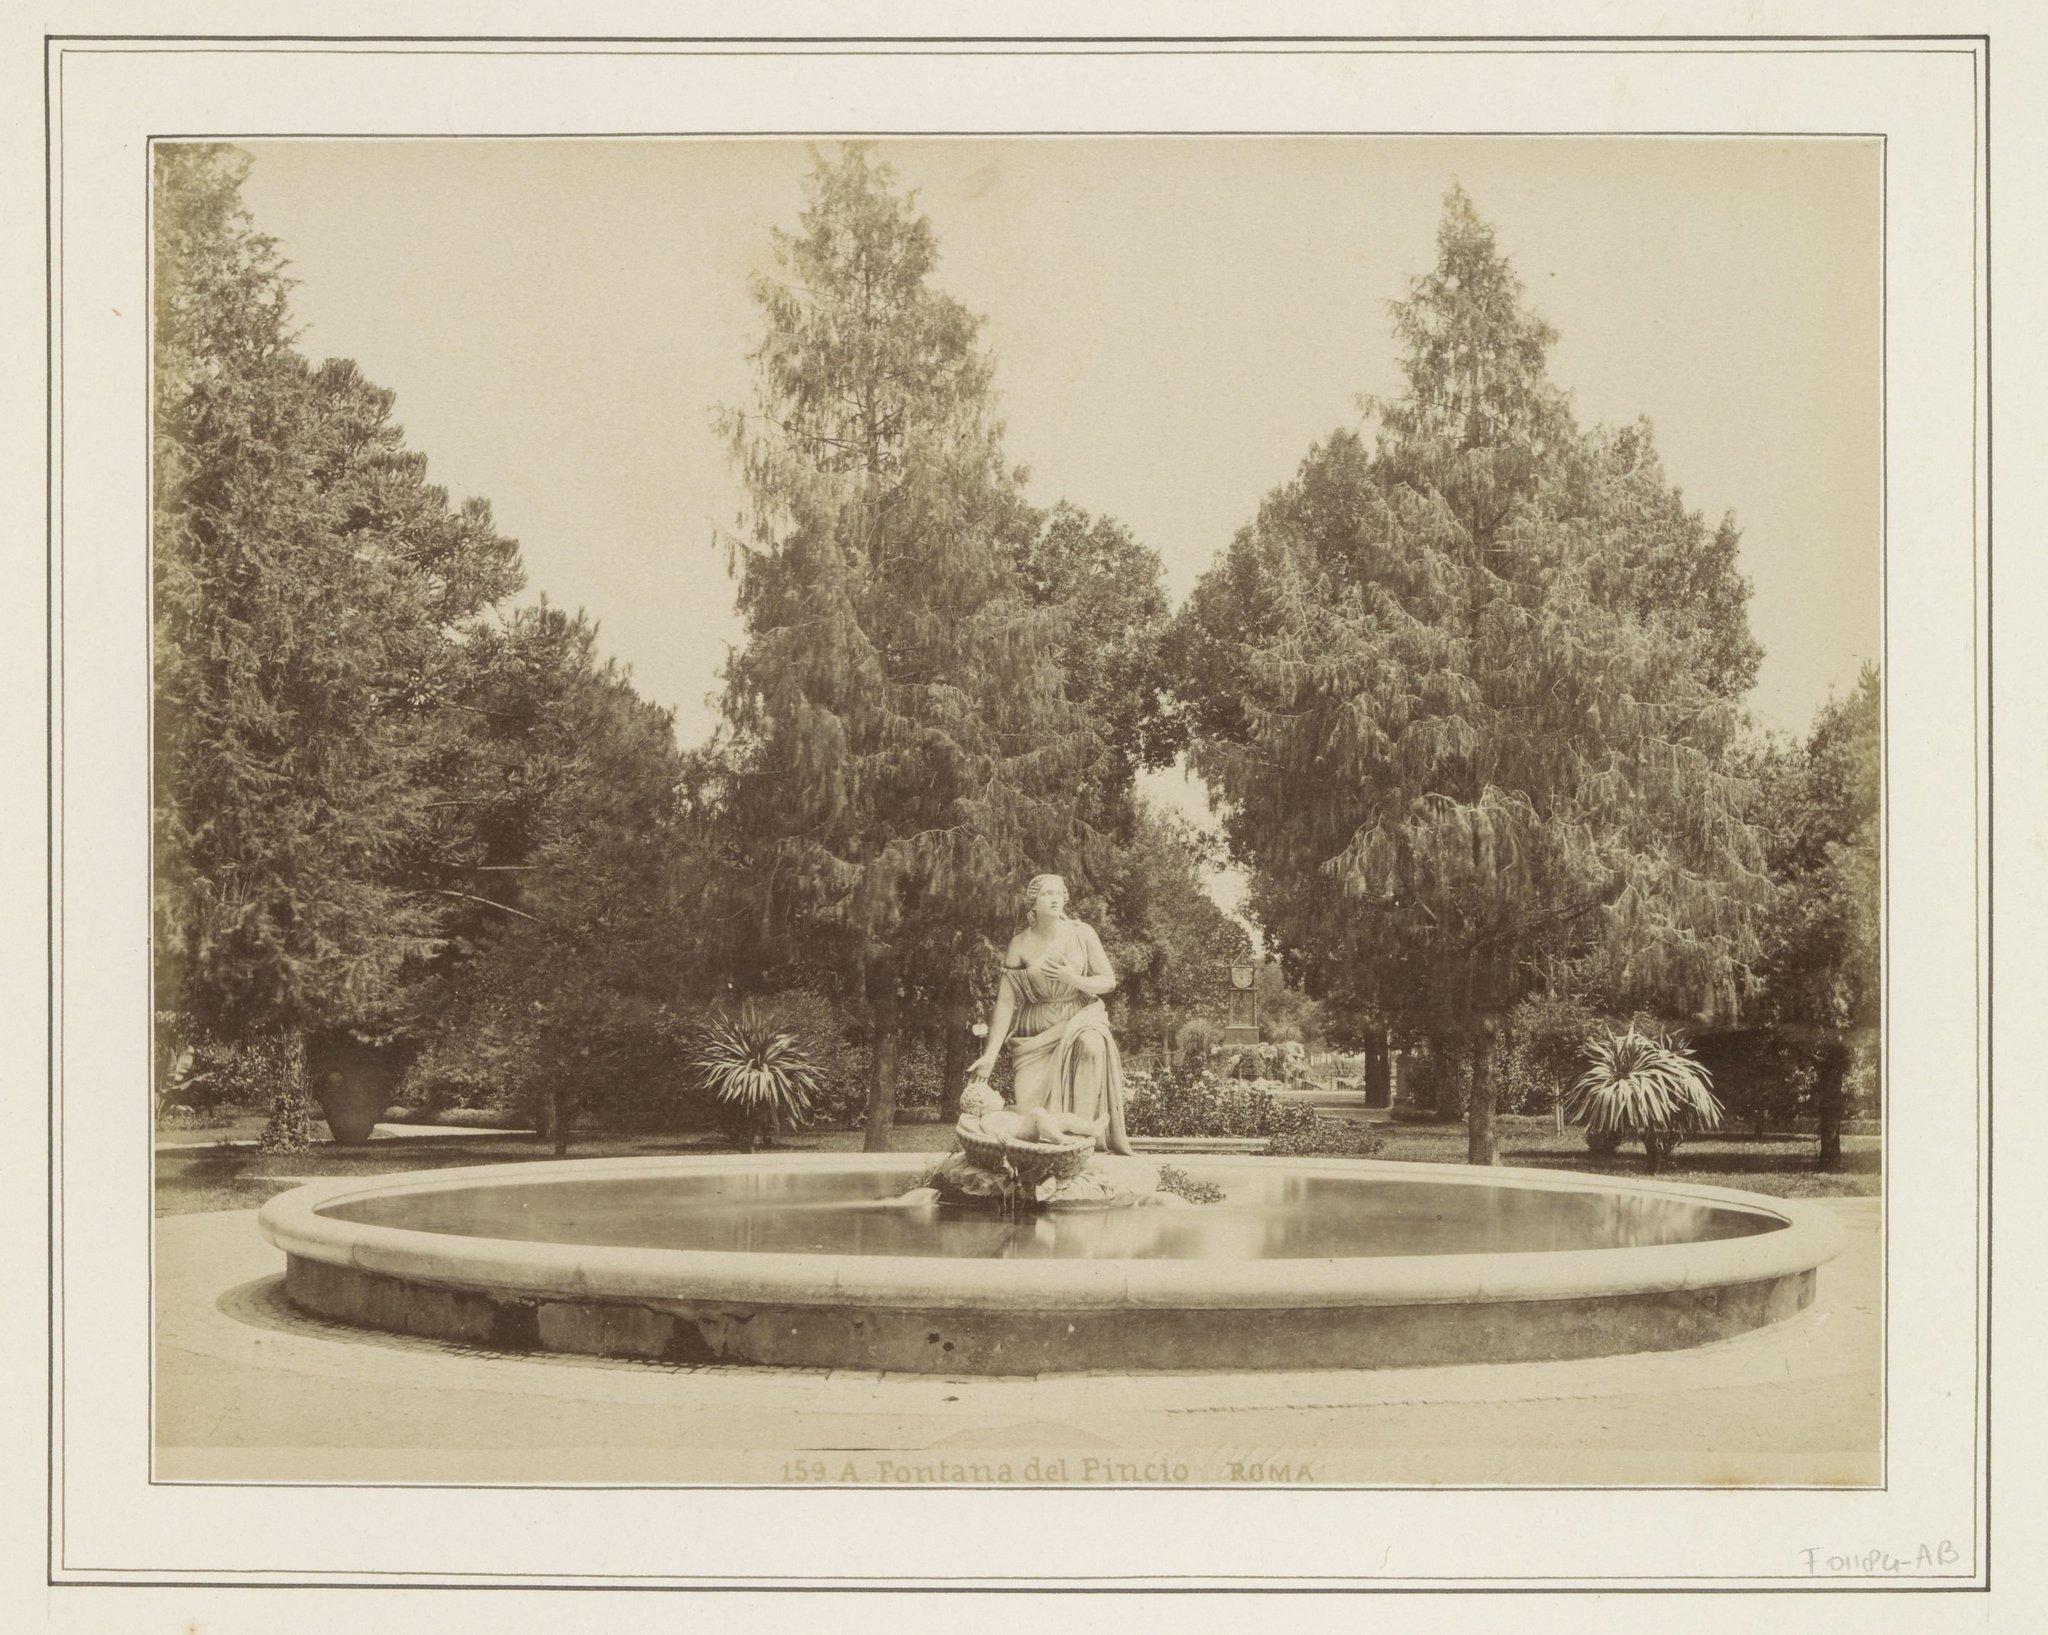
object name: photograph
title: Fontana del Pincio ROMA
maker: Anonymous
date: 1865-1890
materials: paper, photographic support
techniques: albumen print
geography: rome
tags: piece of sculpture, reproduction of a piece of sculpture, water-works in garden, ornamental fountain, rome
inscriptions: negative number: ‘159A’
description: Onderdeel van Reisalbum met foto's van bezienswaardigheden in Italië (deel I).